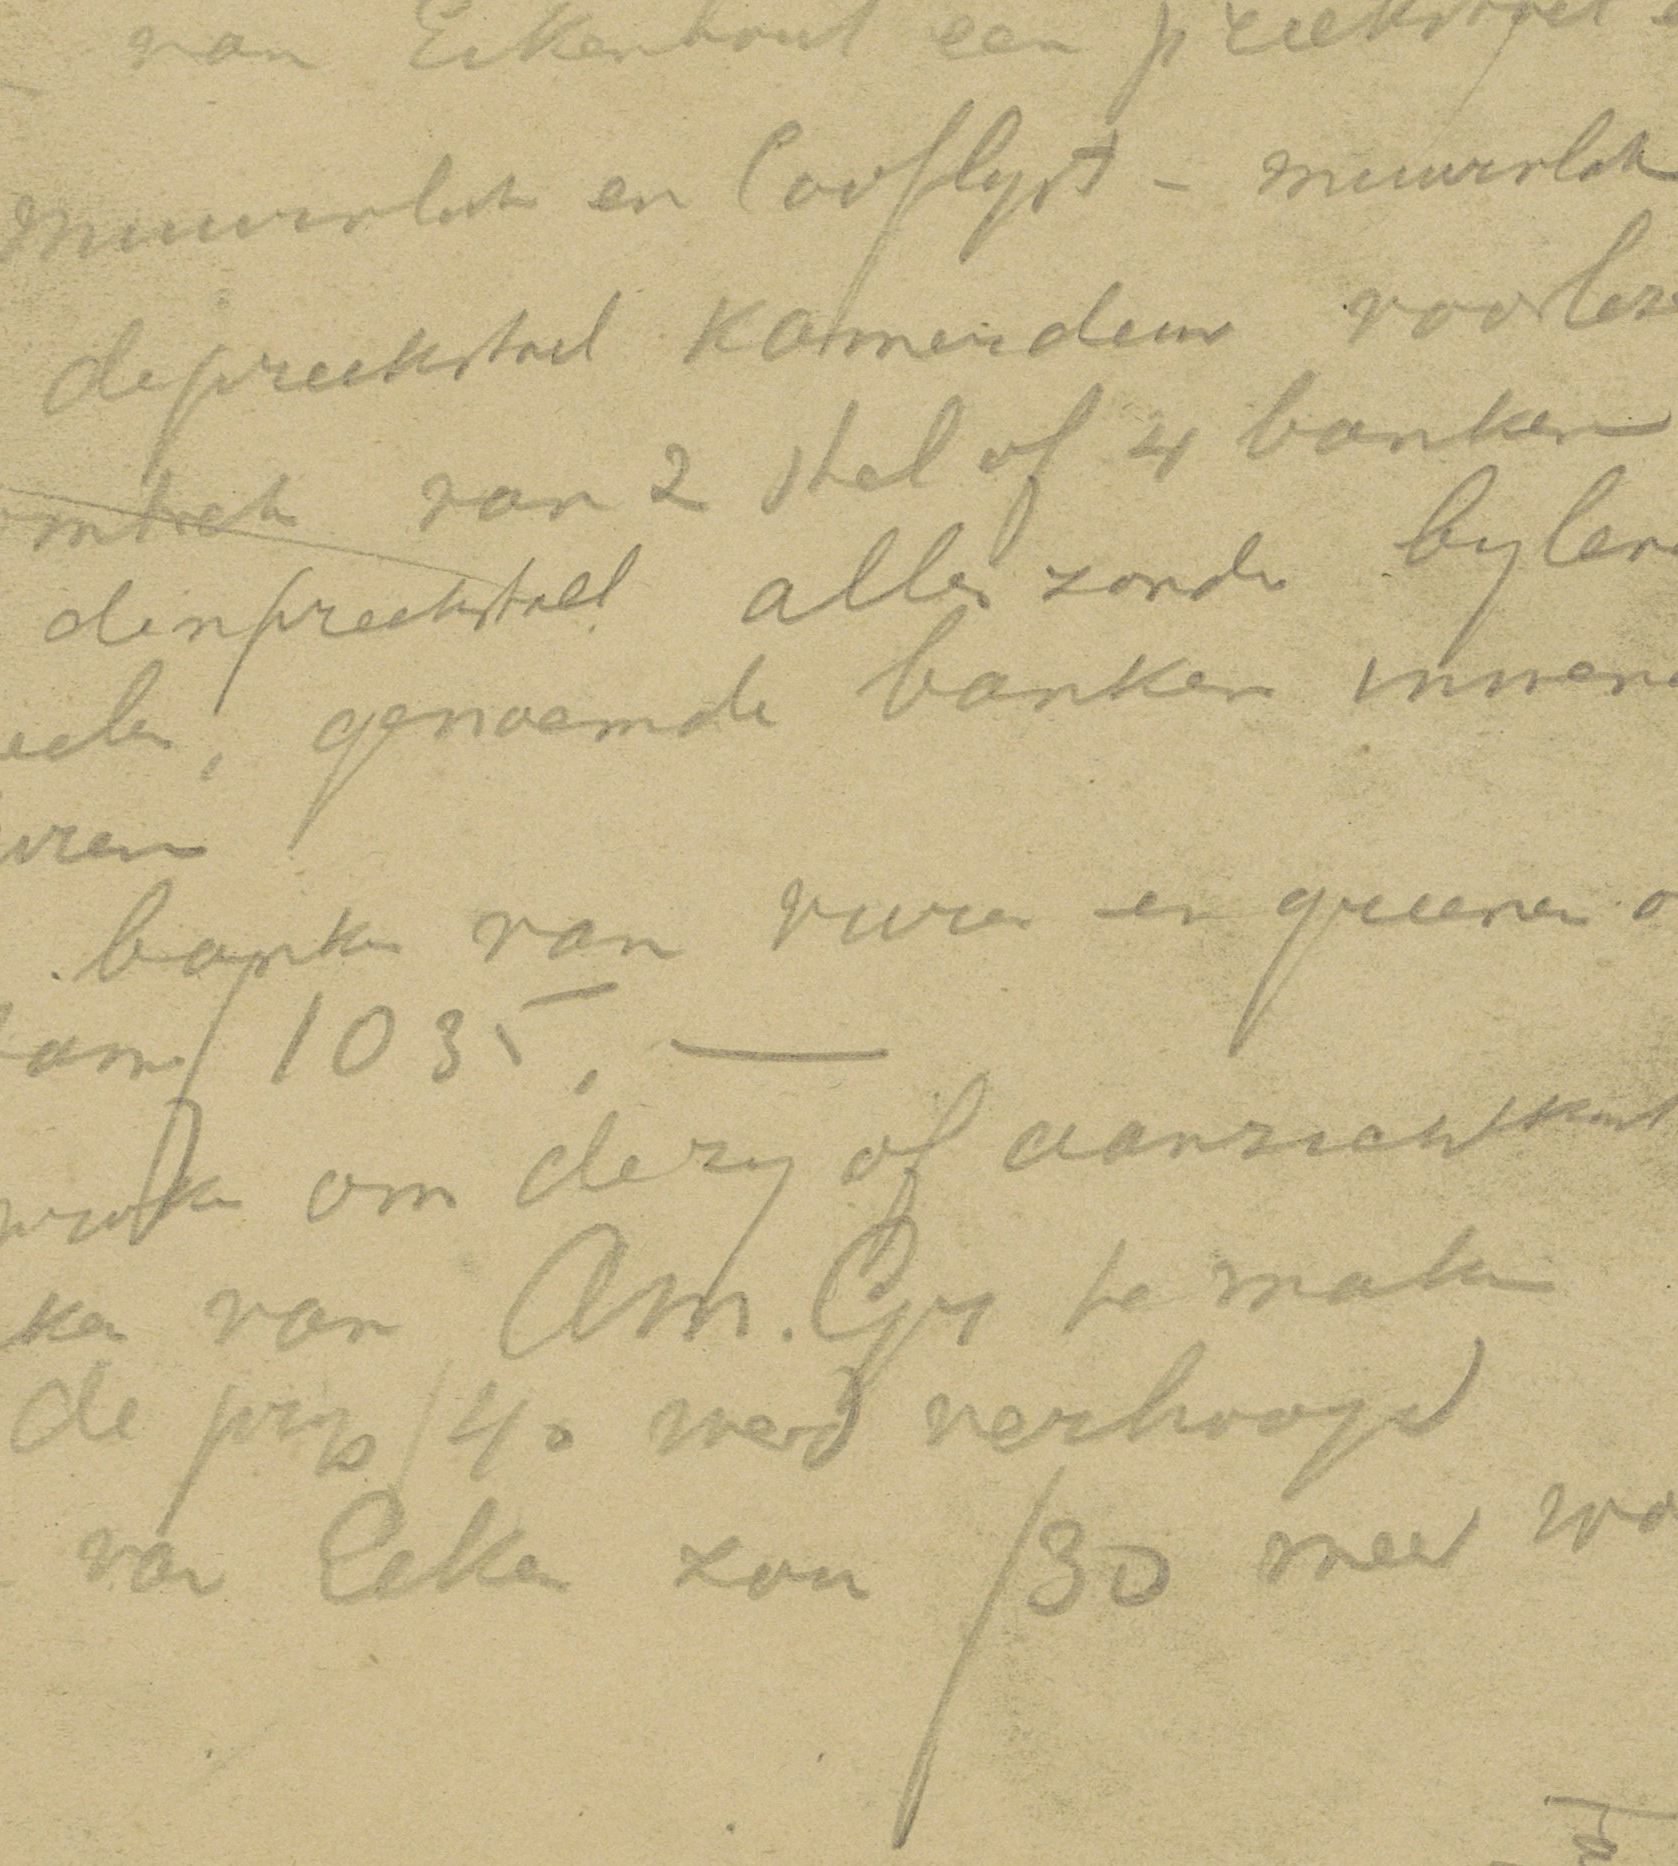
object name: sketchbook leaf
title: Studie, mogelijk een architectuurdetail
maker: carel adolph lion cachet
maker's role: draughtsman, print maker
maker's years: 1864-1945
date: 1906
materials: paper, pencil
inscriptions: annotation: ‘[...]’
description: Blad 27 verso uit een schetsboek met 27 bladen.